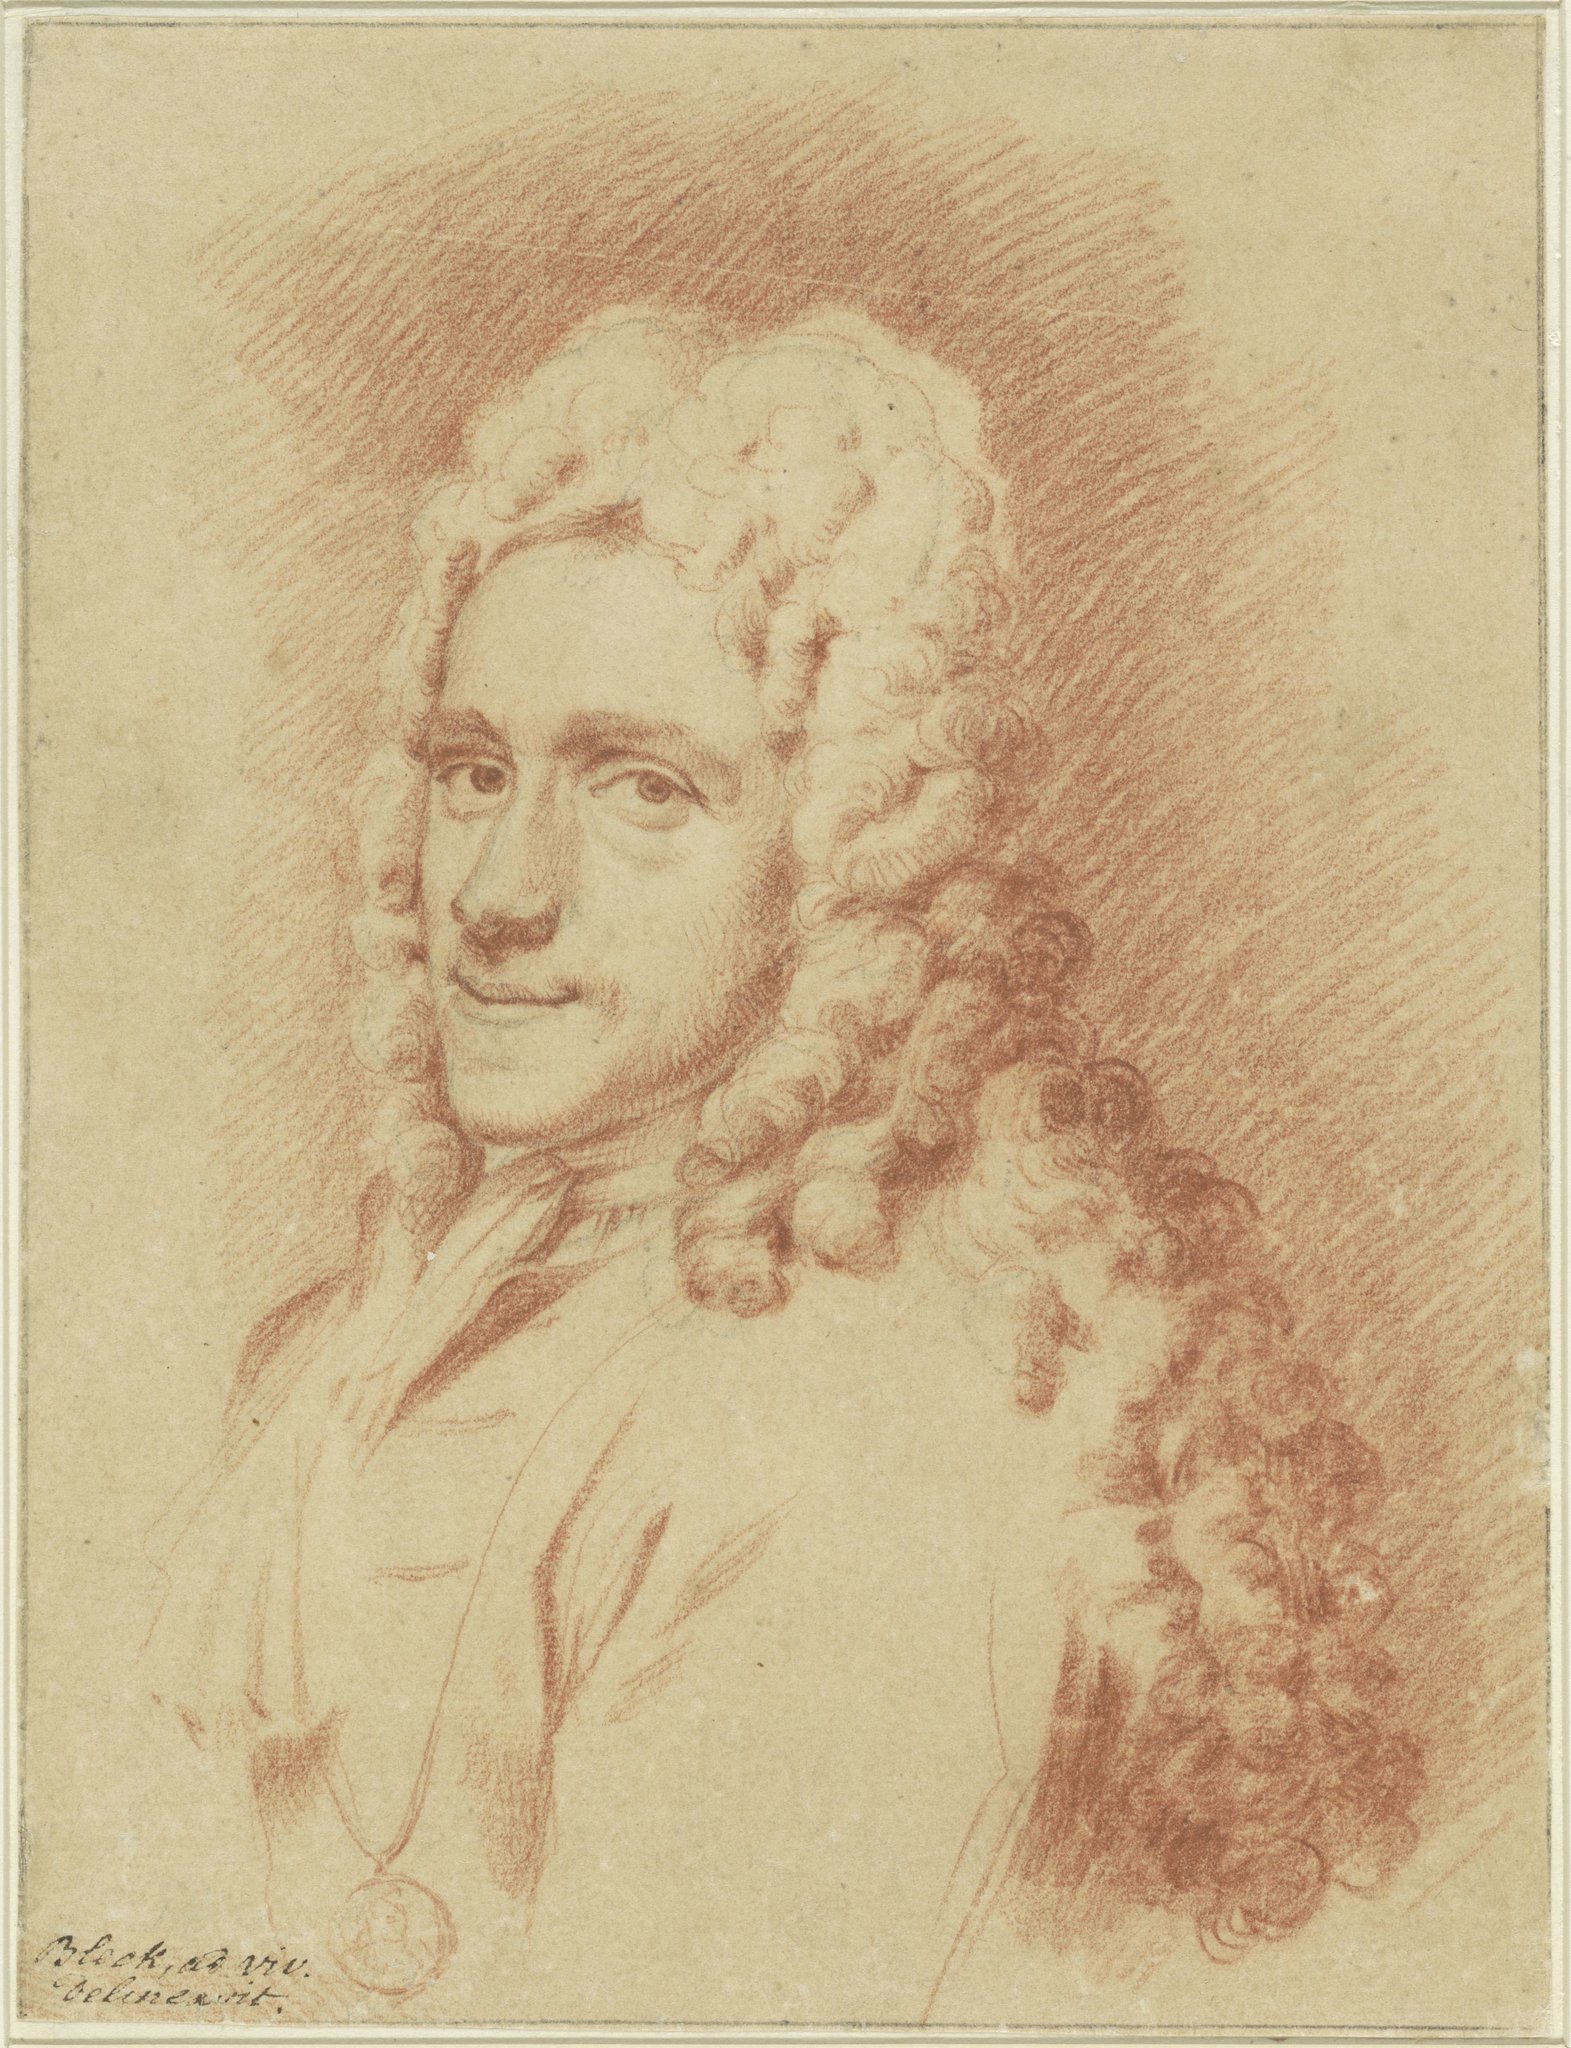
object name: drawing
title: Portret van Coenraat Roepel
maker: richard van bleeck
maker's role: draughtsman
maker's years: 1670-1748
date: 1680-1748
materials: chalk, paper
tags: painter, coenraet roepel, historical persons, portrait, self-portrait of artist